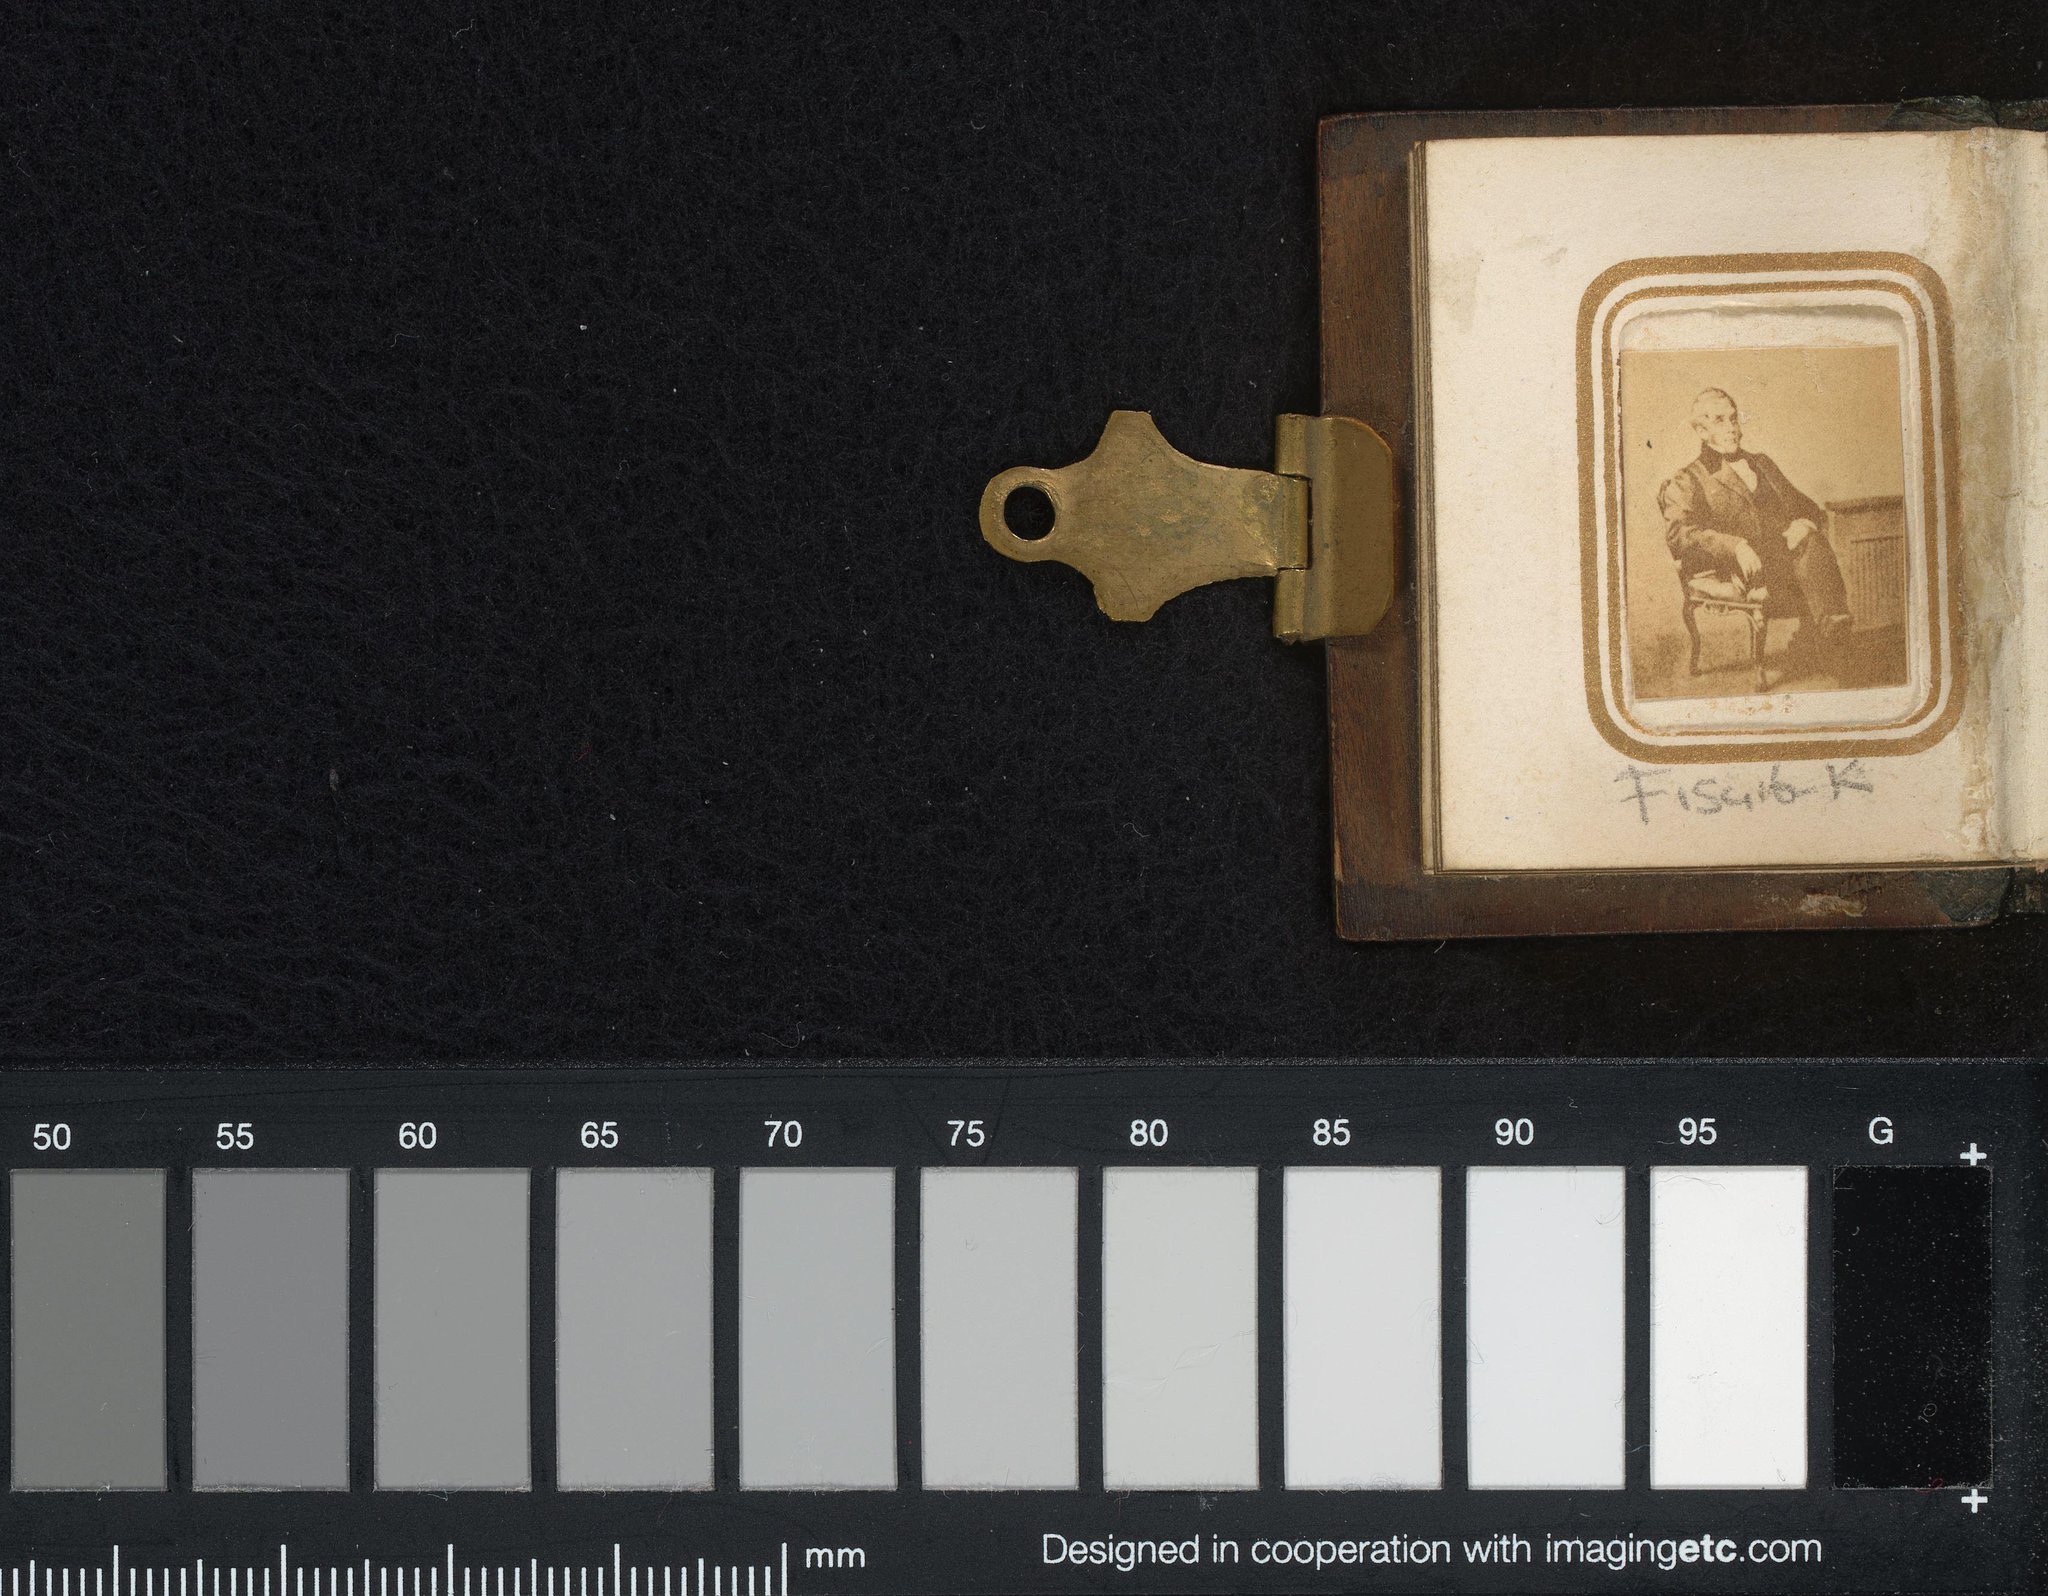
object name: reproduction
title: Fotoreproductie van een portret van een zittende man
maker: Anonymous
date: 1851-1900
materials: paper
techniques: albumen print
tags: adult man, anonymous historical person portrayed